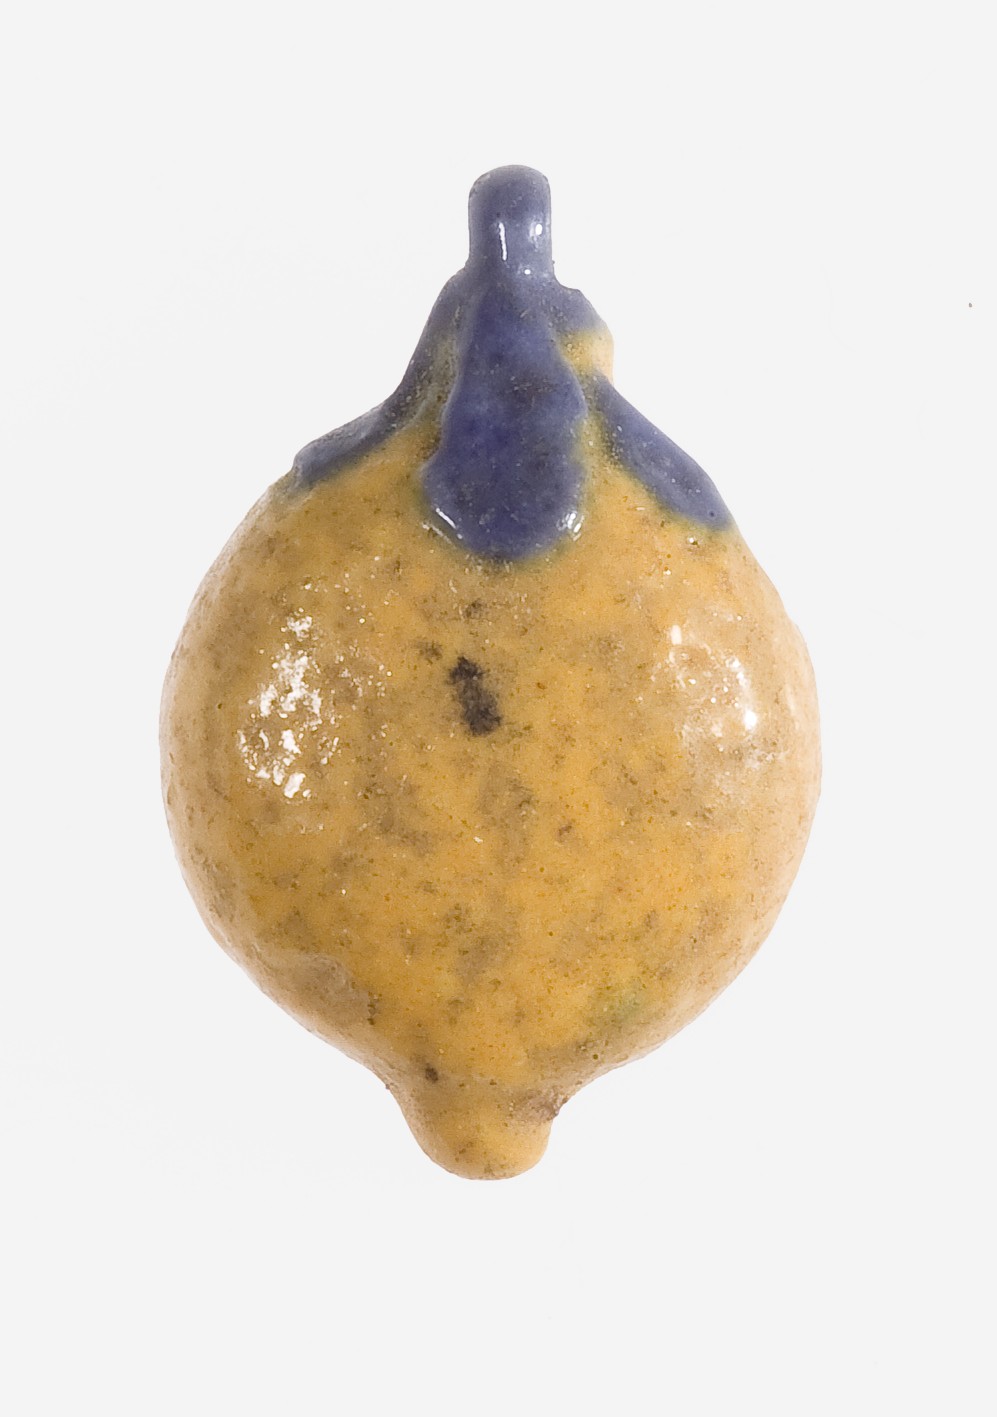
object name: pendant, persea fruit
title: Persea fruit pendant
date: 1390-1352 BCE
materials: faience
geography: egypt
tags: fruit